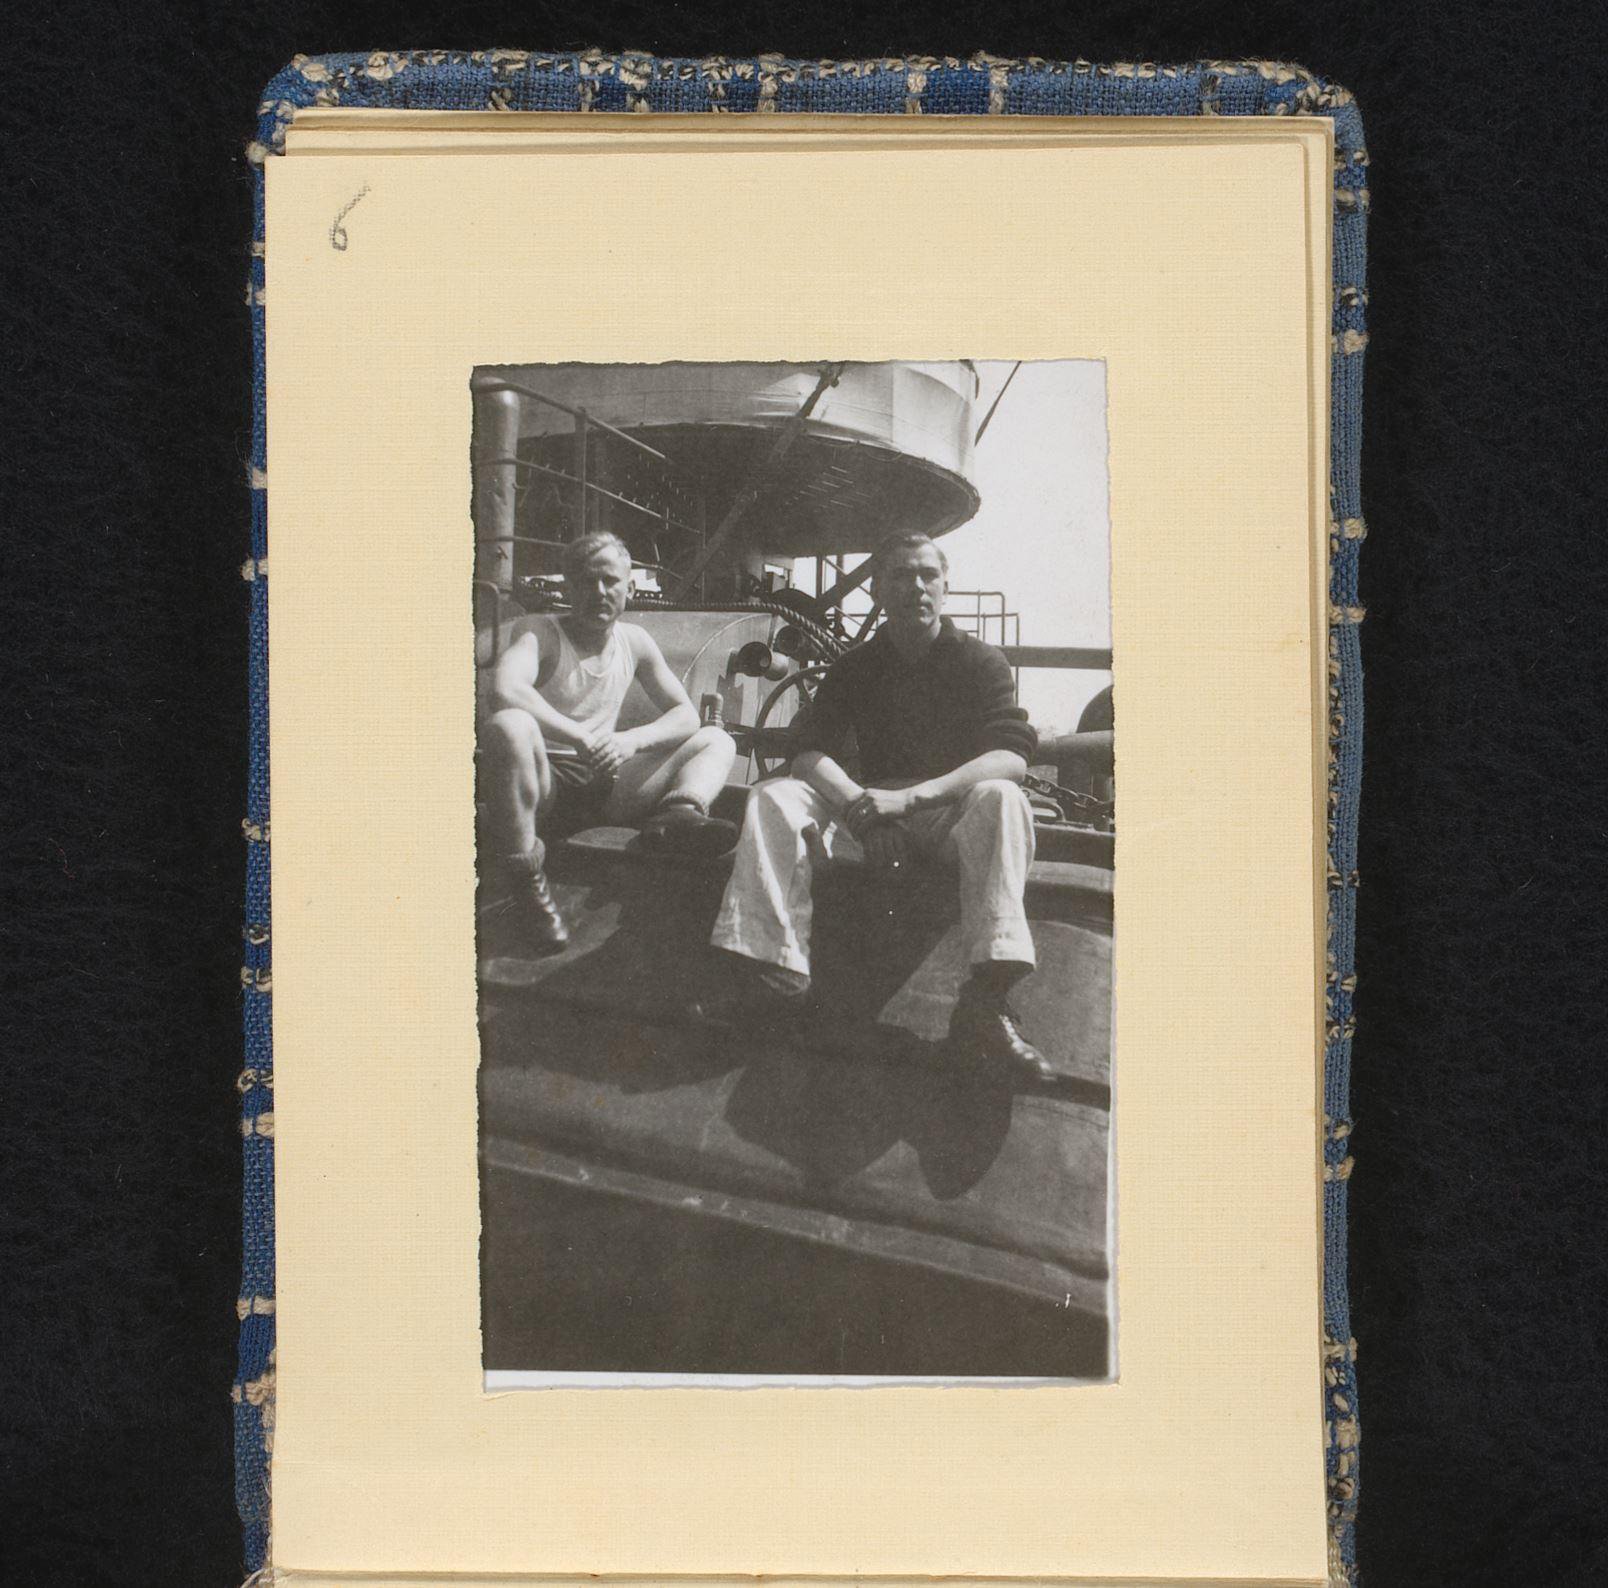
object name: photograph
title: Aan dek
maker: Anonymous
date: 1940-1943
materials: photographic support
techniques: gelatin silver print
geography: netherlands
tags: the company, the unit, the troop ~ military service, sailor, netherlands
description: Twee Duitse matrozen zittend op het dek van een schip. Onderdeel van het fotoalbum over de Kriegsmarine 1940-1943.